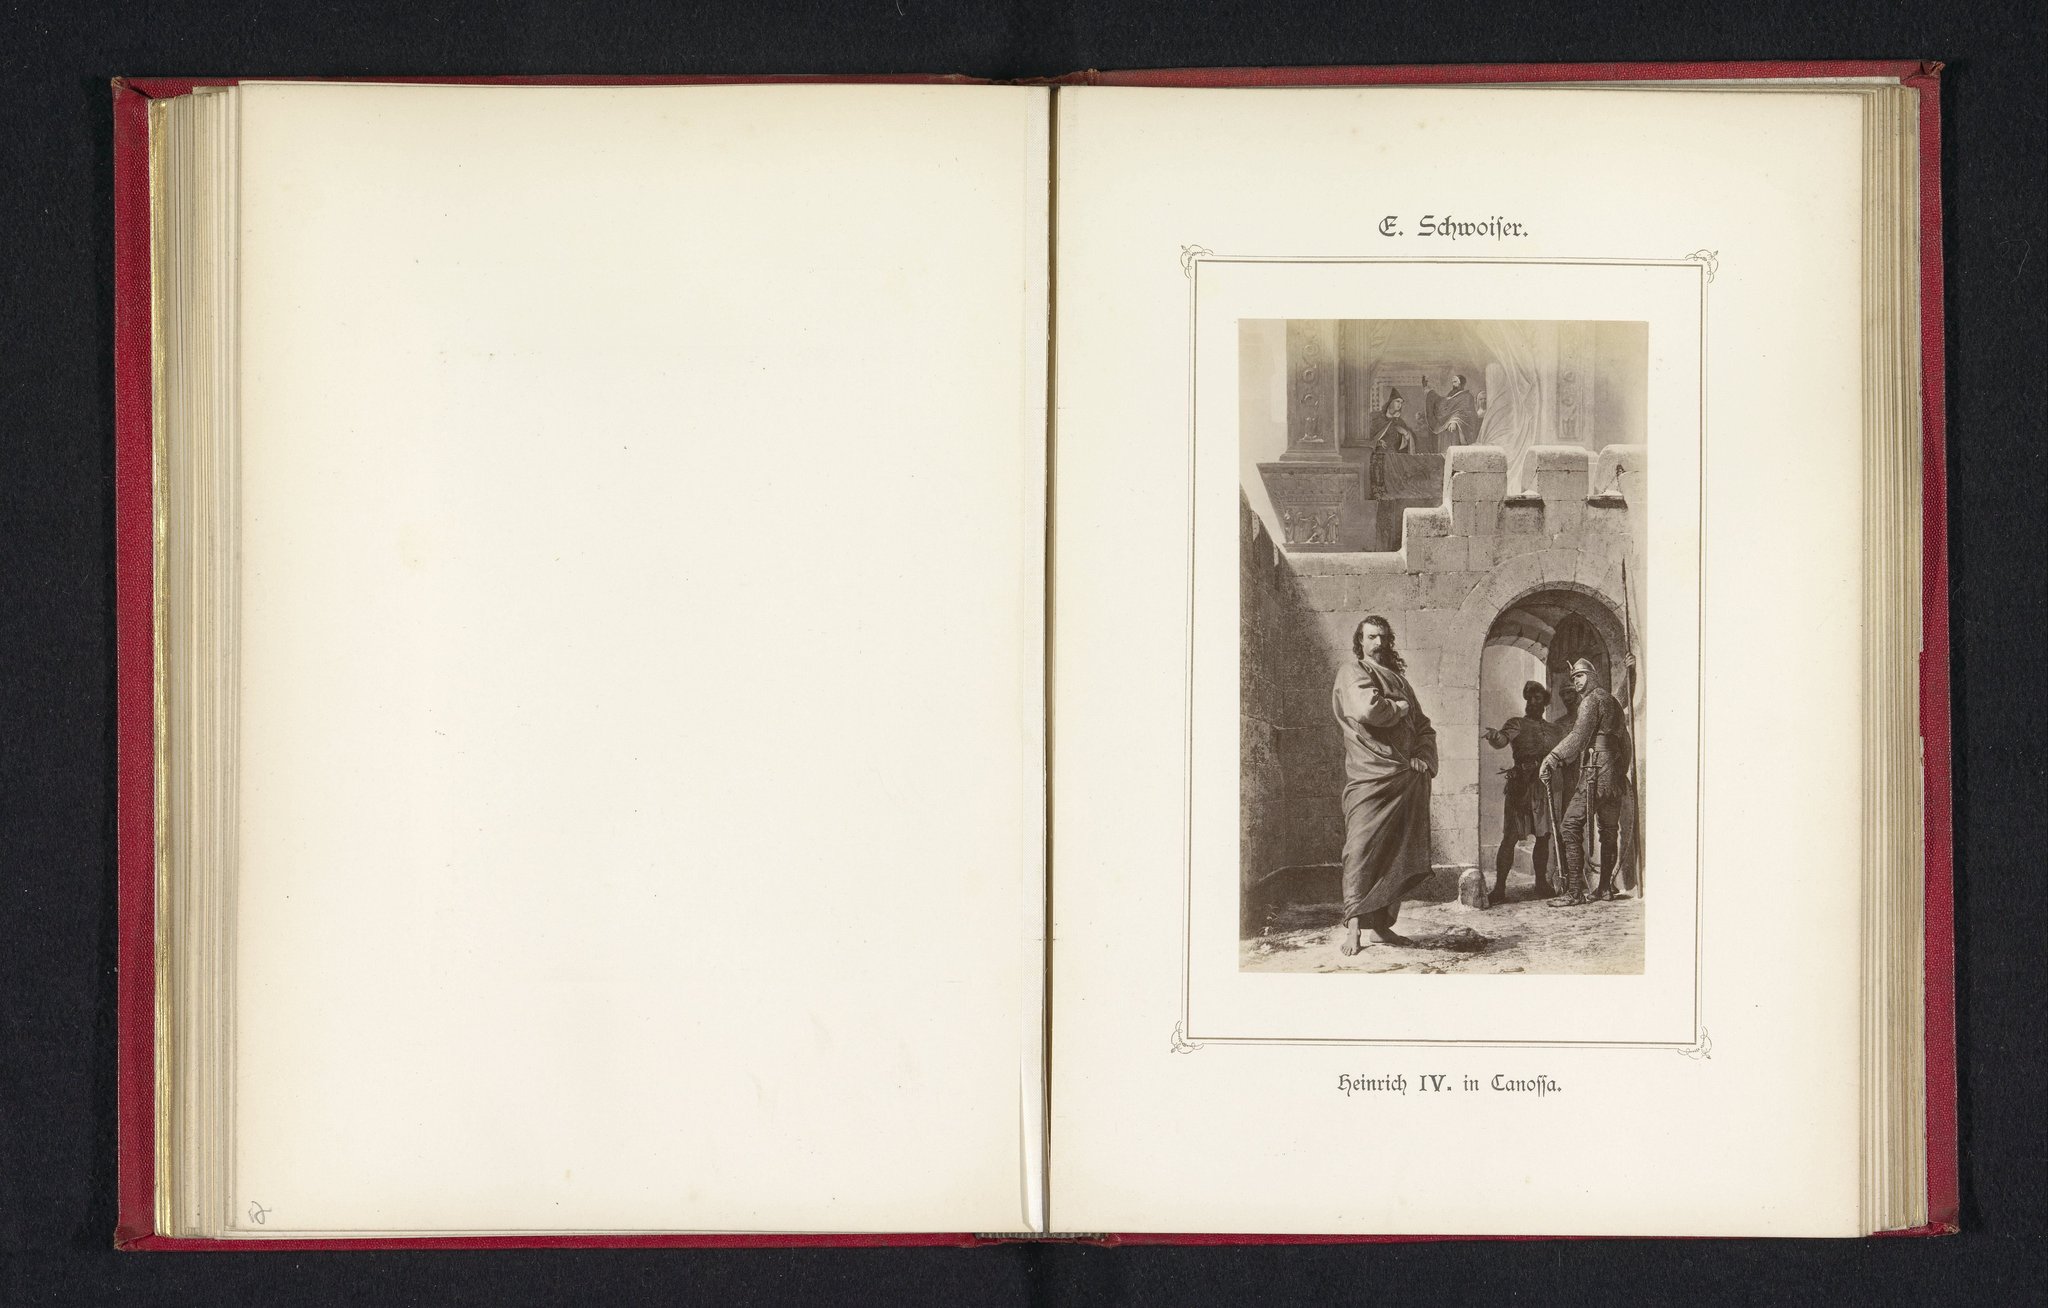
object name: photograph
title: Heinrich IV. in Canossa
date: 1875-1880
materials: photographic support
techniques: albumen print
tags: emperor